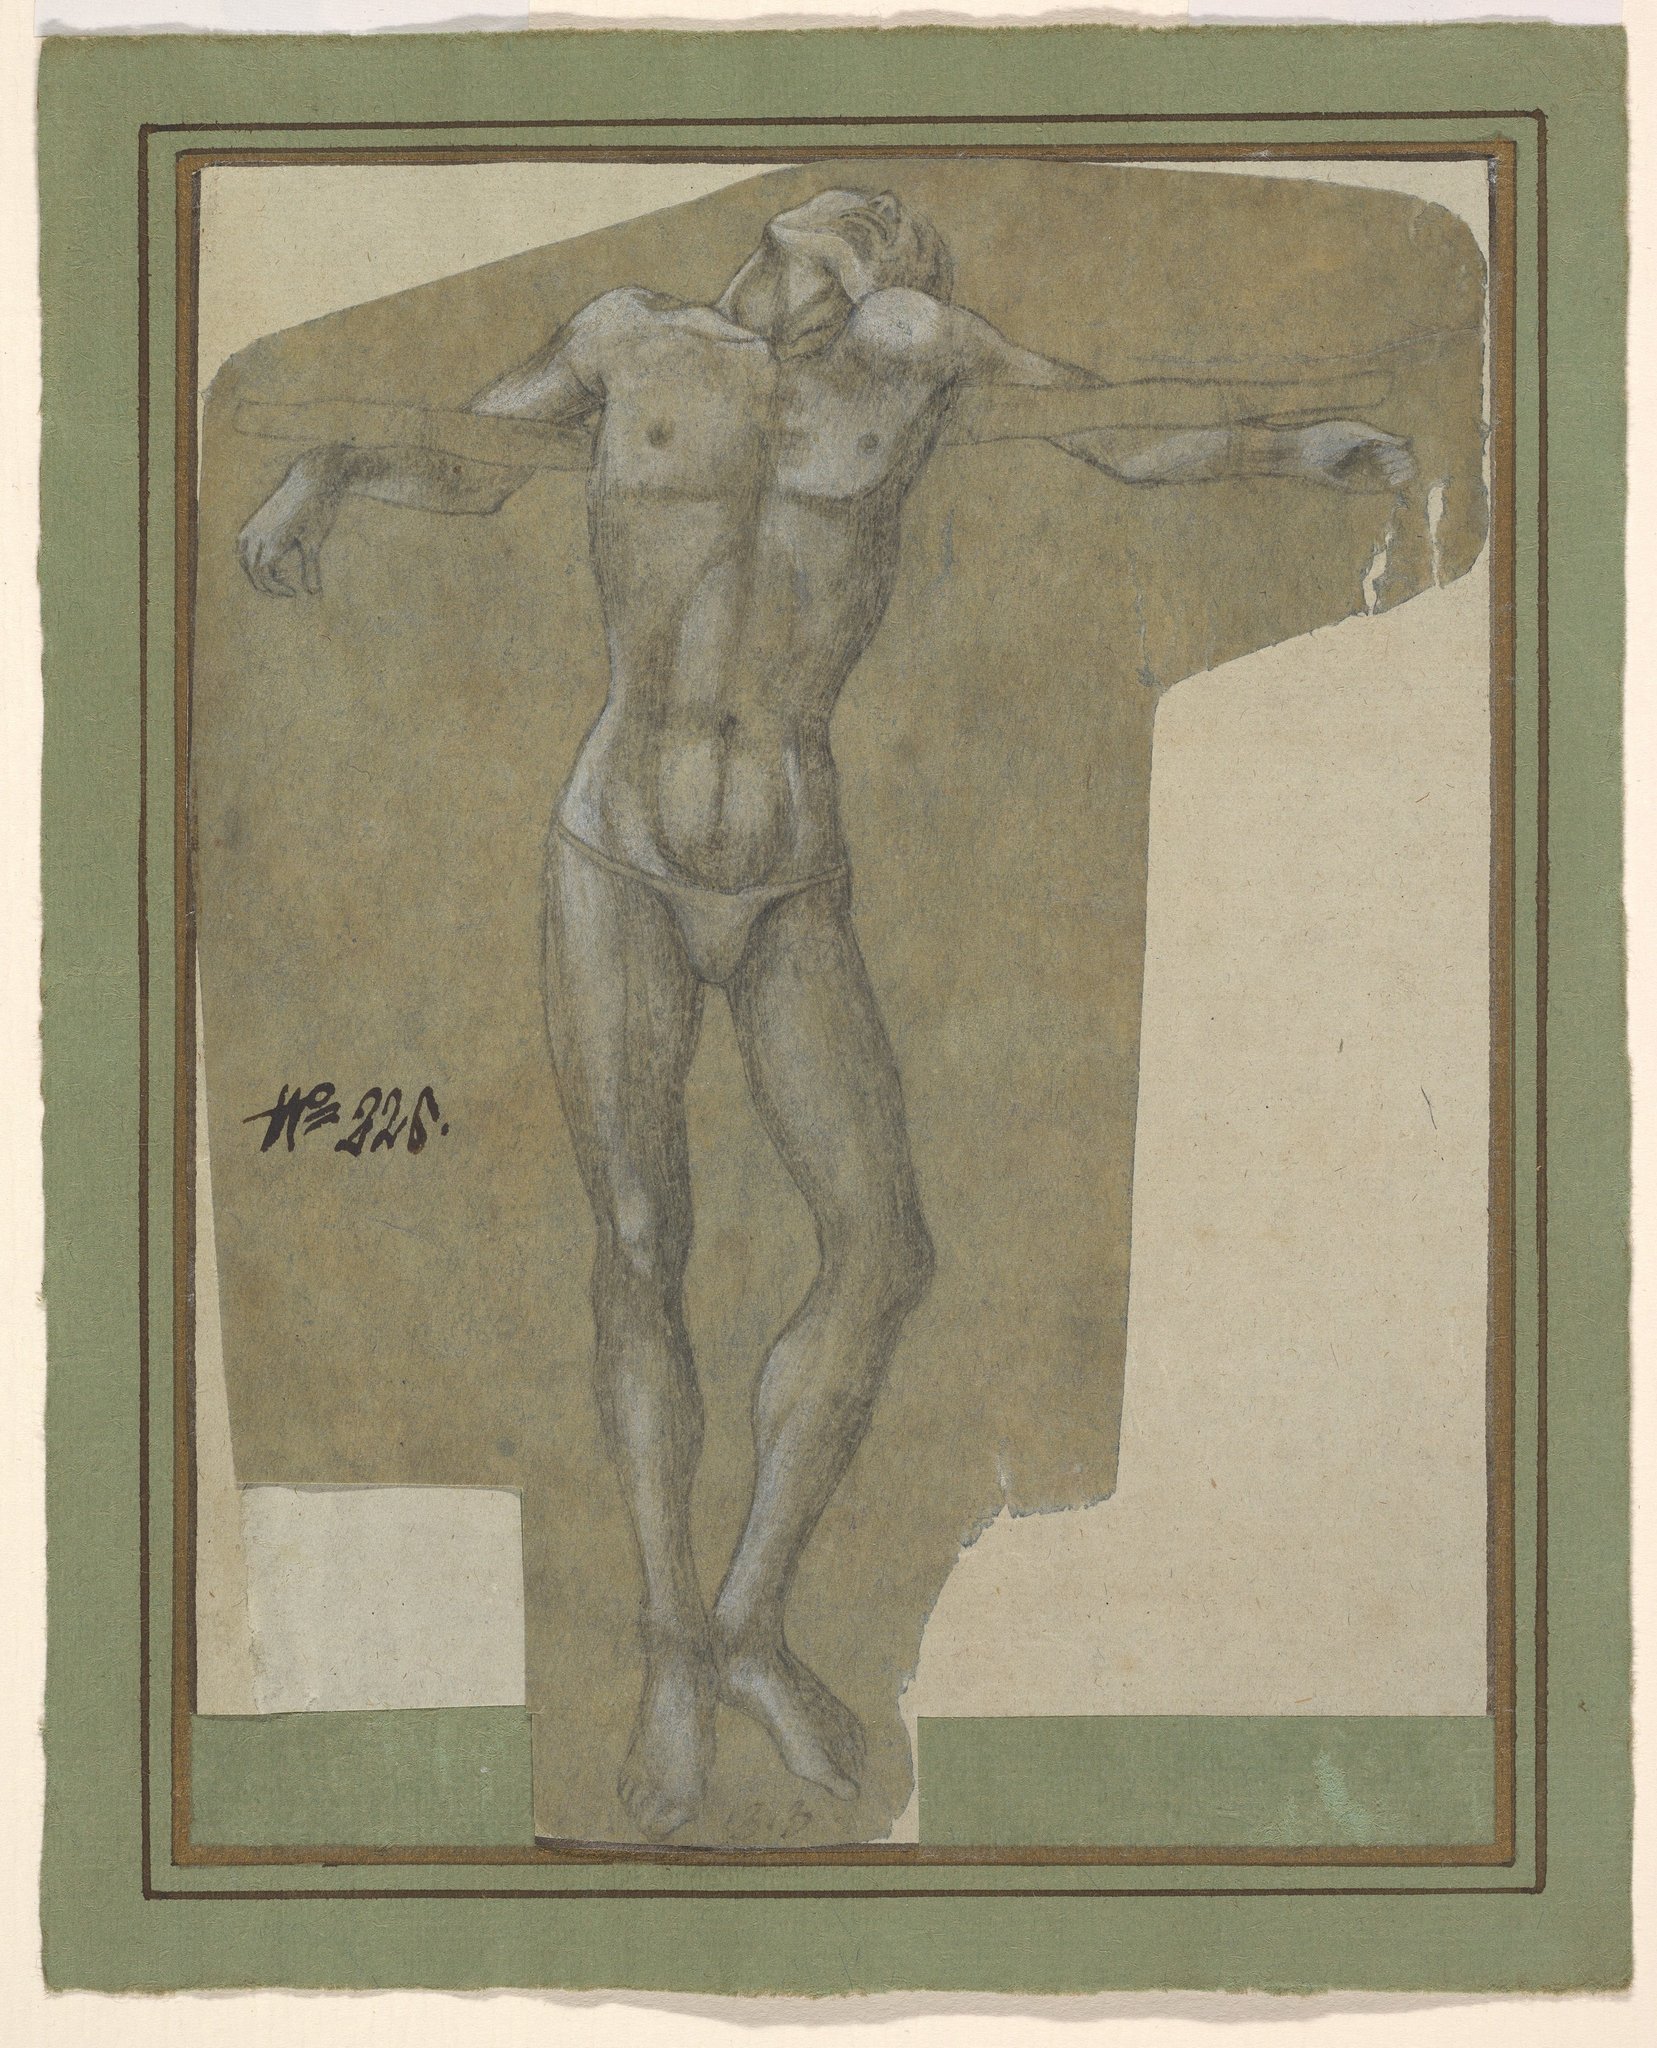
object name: drawing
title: The Good Thief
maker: anonymous, italian, ferrarese, 15th century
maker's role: artist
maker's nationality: italian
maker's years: 1400-1500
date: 1470-1480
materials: charcoal, gouache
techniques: highlighting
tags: men